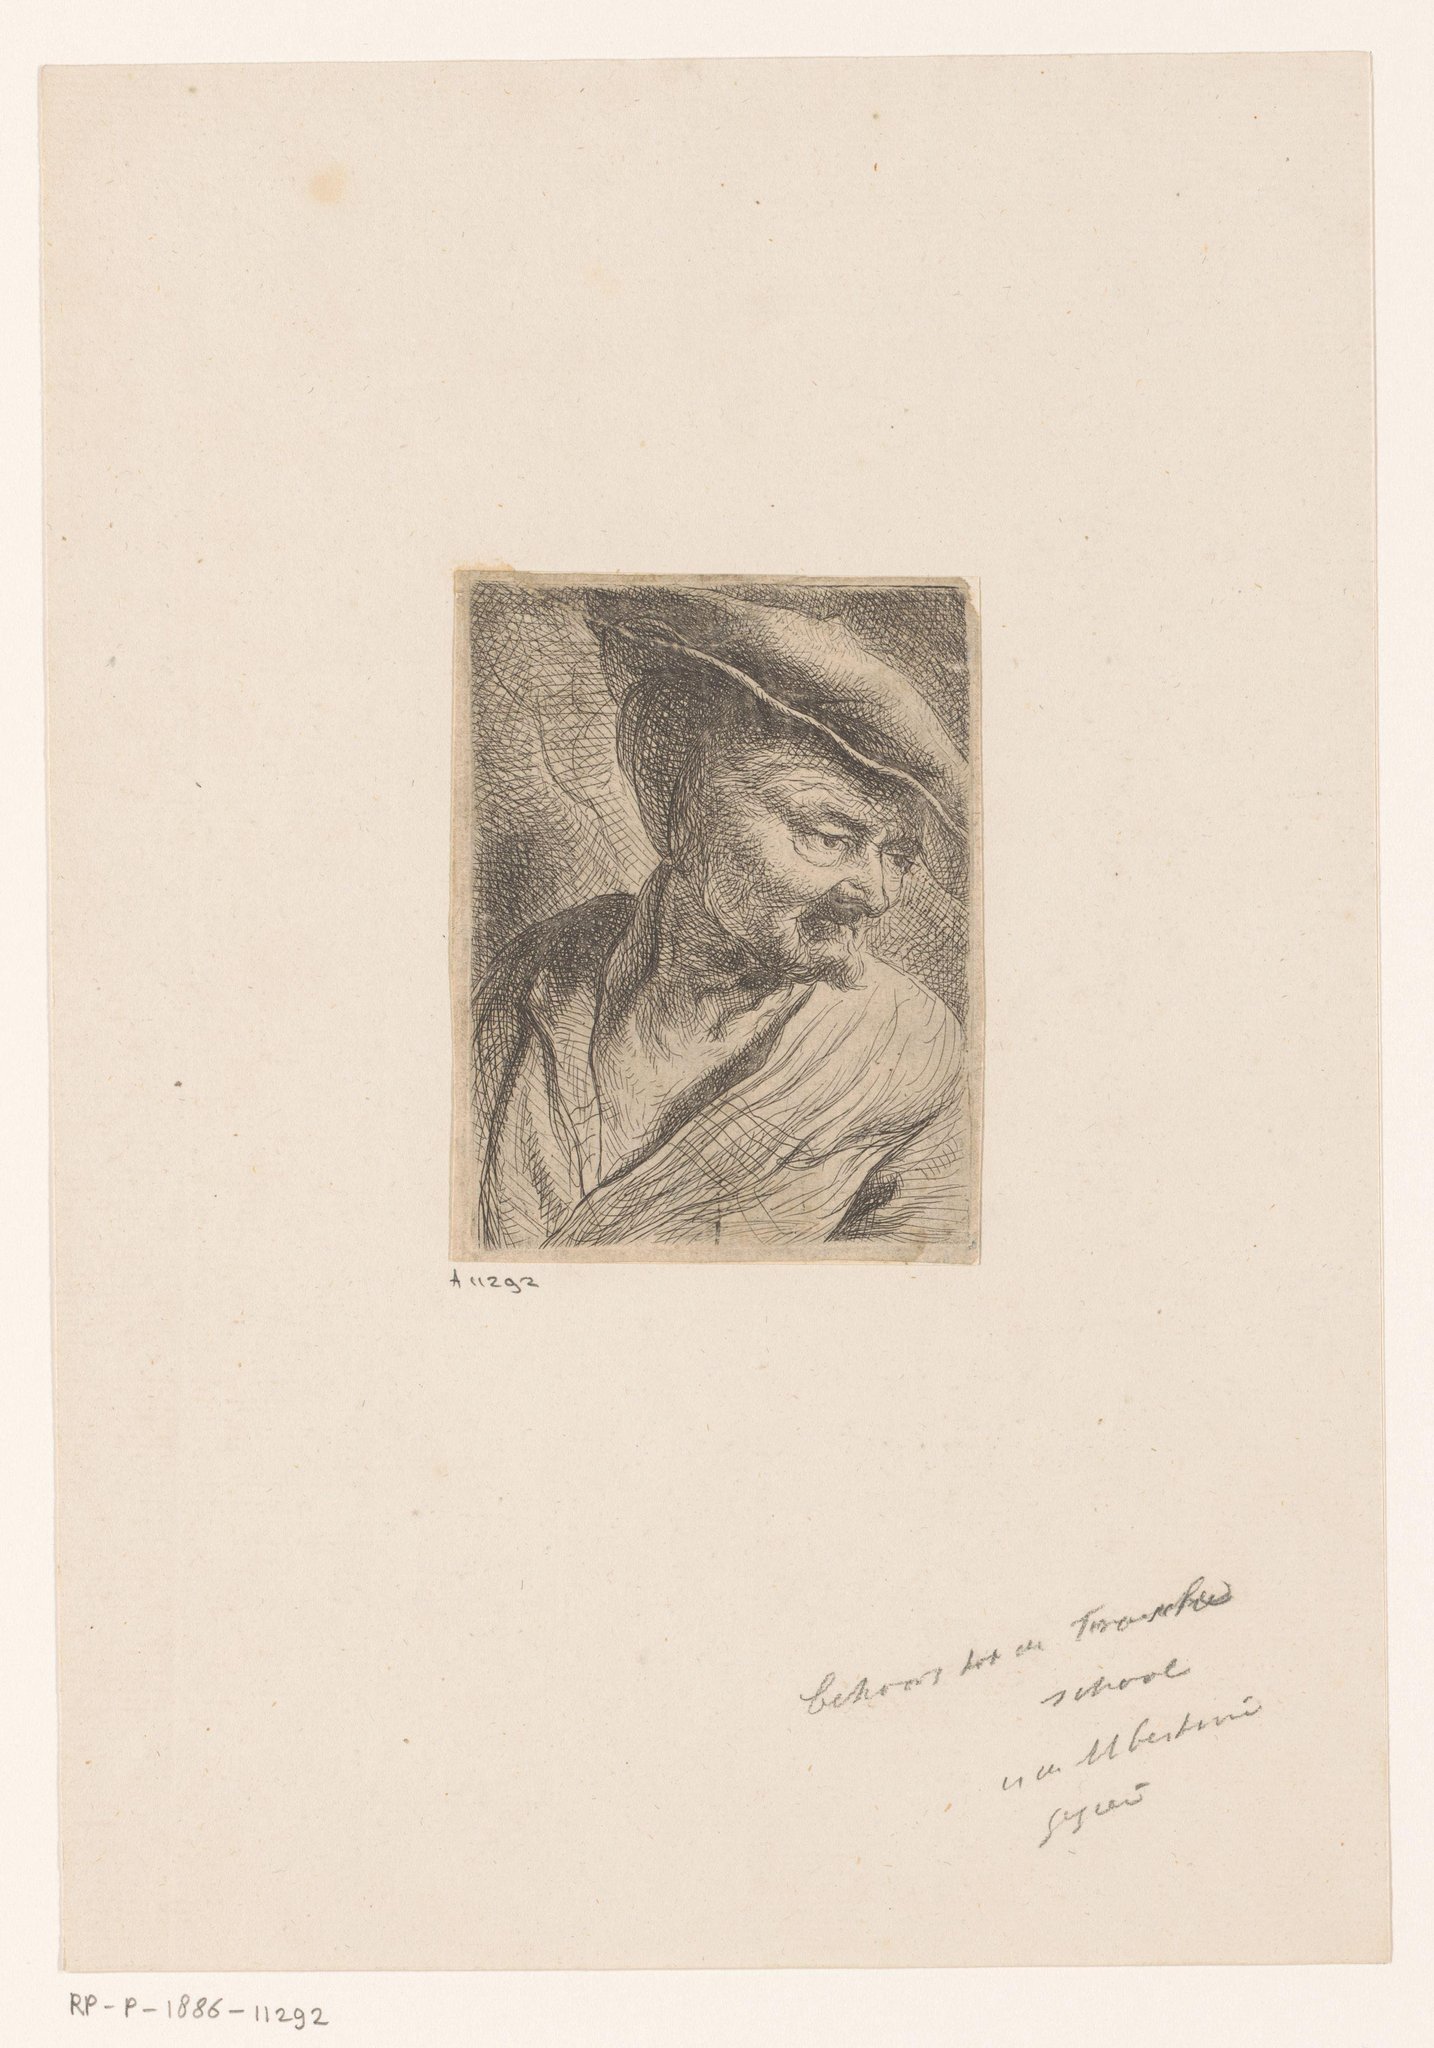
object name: print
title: Buste van een man met korte baard en platte pet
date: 1750-1850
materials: paper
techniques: etching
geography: france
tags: head-gear: cap (+ men's clothes)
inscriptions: collector's mark: Lugt 2228